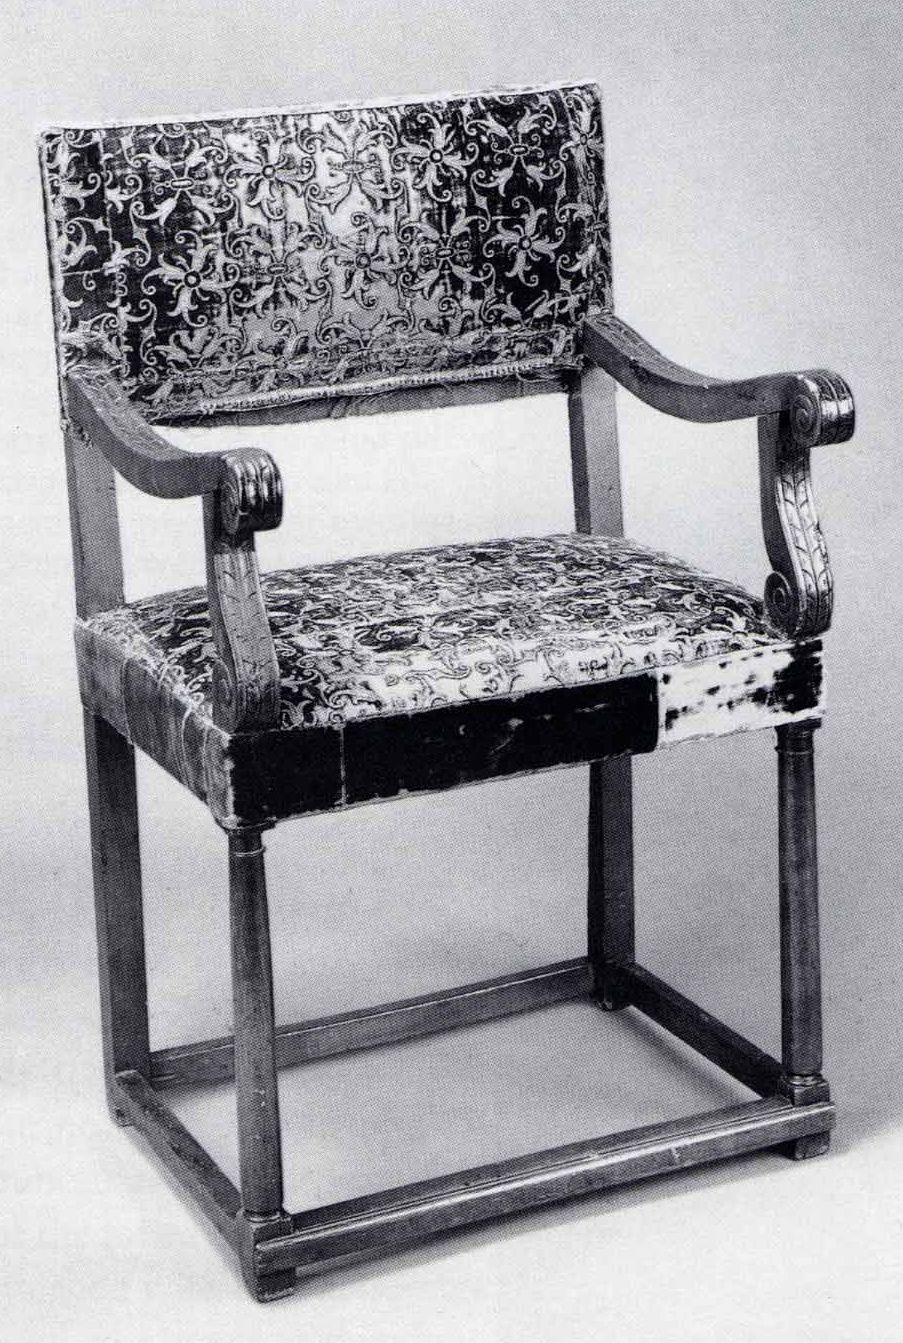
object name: armchair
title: Armchair (chaise à bras)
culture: french or italian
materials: silk, velvet, wood